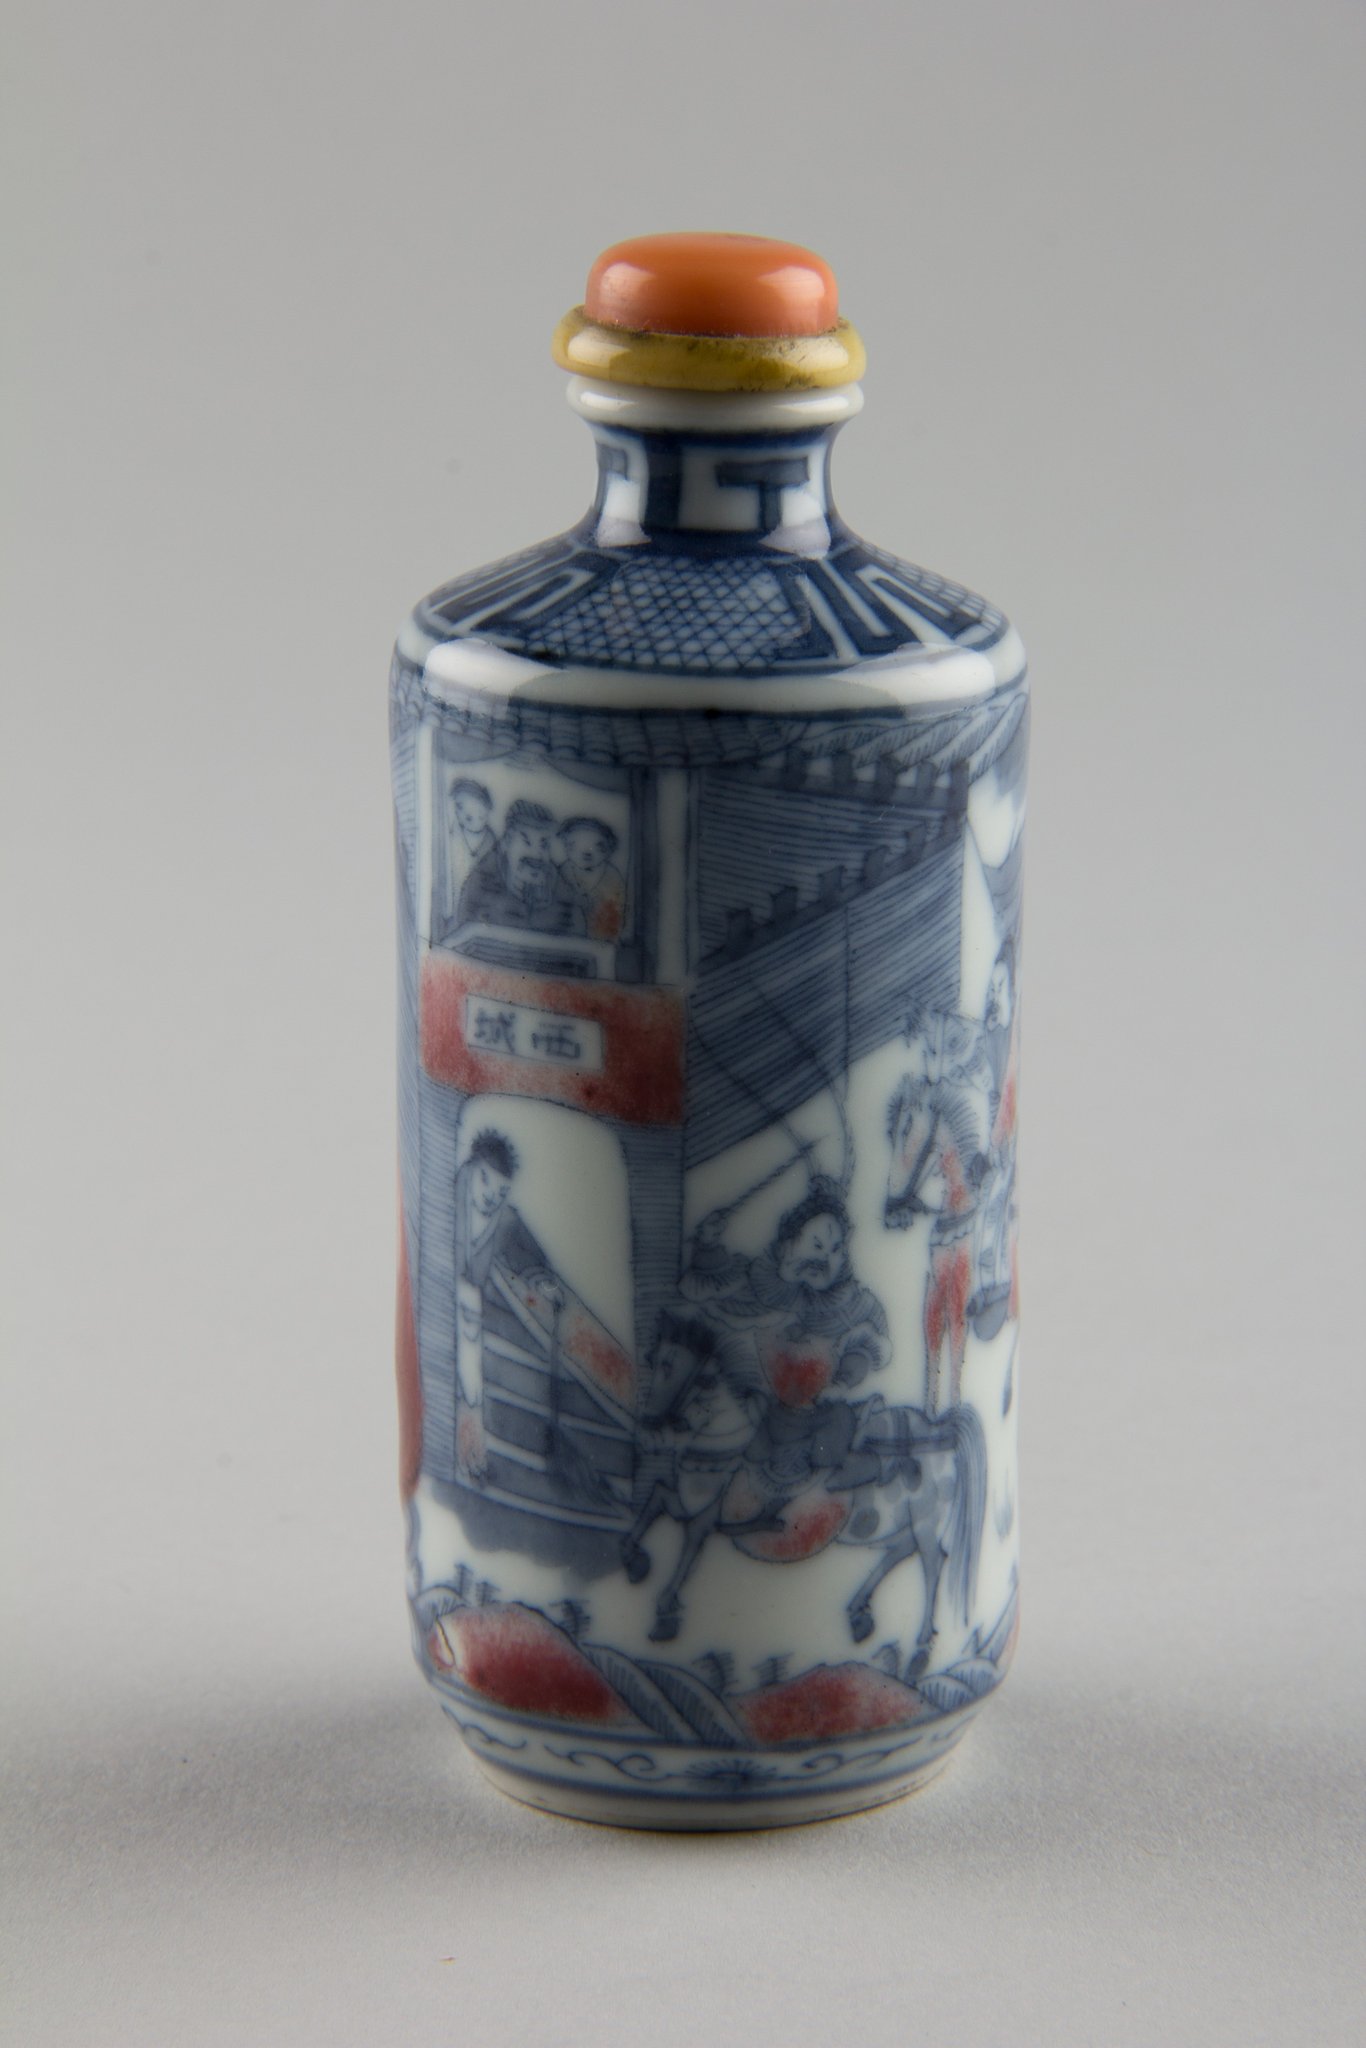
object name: snuff bottle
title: Snuff bottle with theatrical scene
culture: chinese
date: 1867-1900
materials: coral, porcelain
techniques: underglaze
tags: men,horses